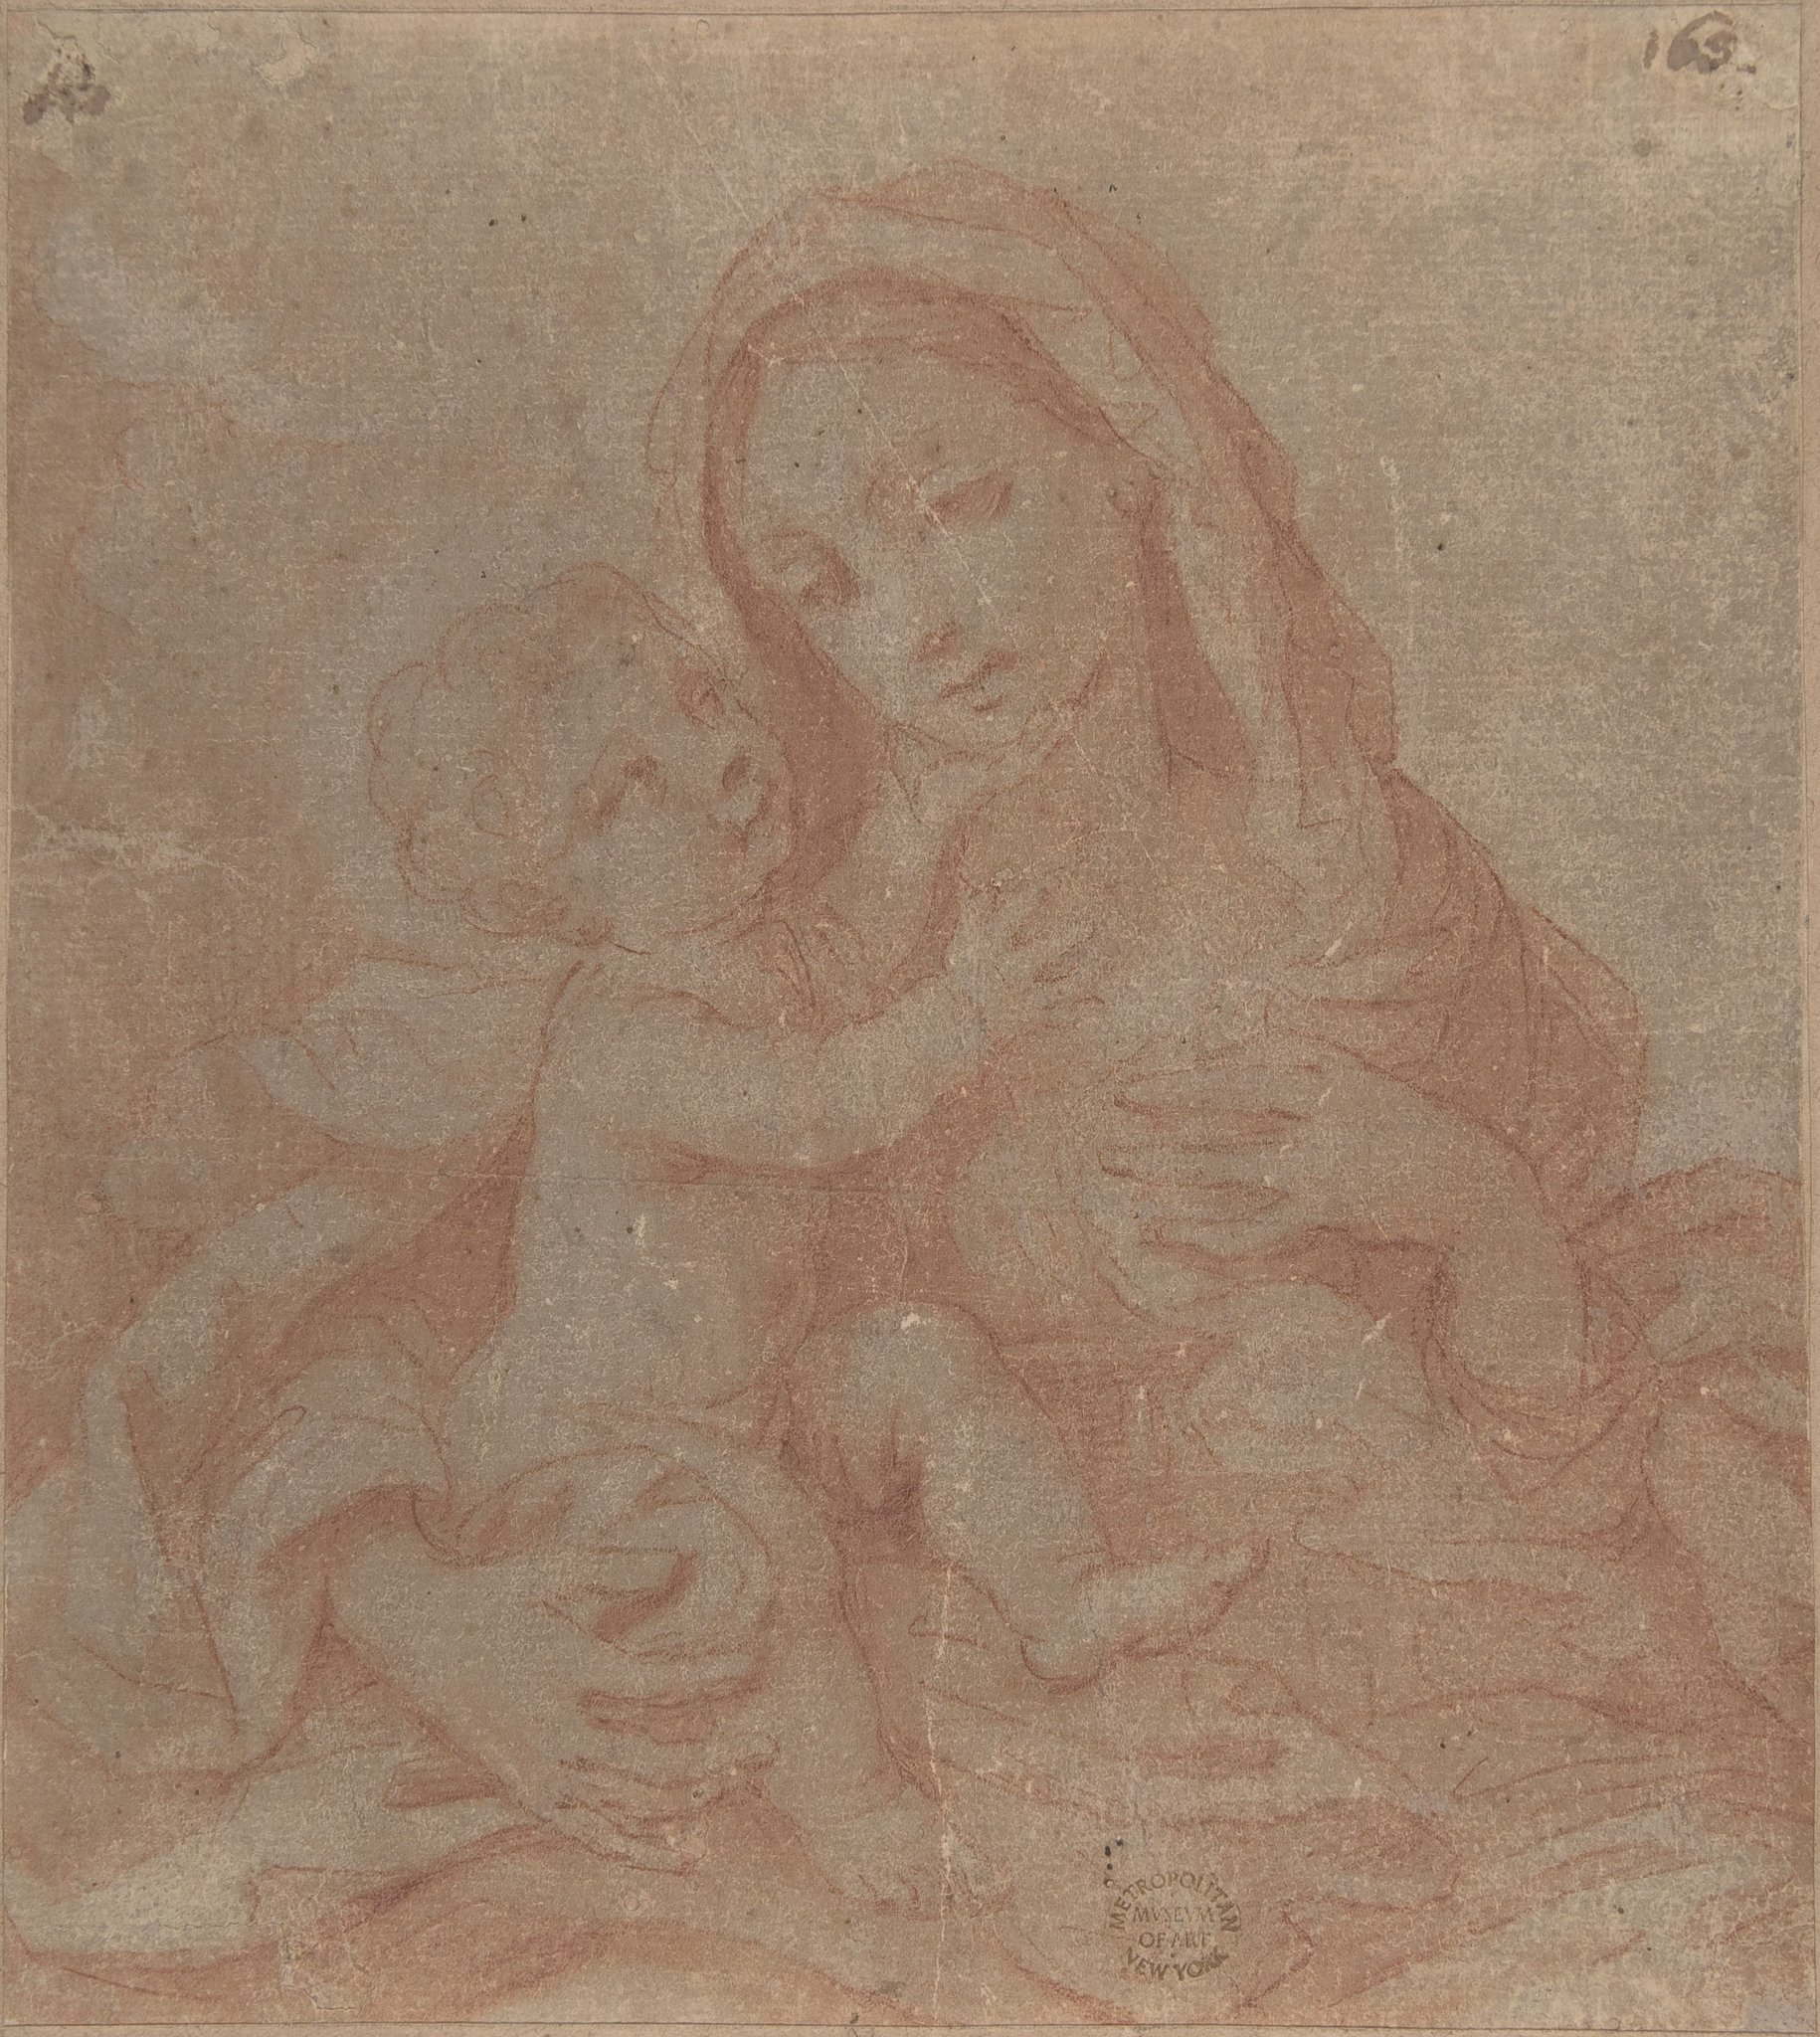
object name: drawing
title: Madonna and Child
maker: anonymous, italian, roman-bolognese, 17th century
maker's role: artist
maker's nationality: italian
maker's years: 1600-1700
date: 1601-1700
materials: chalk, paper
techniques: printmaking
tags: madonna and child